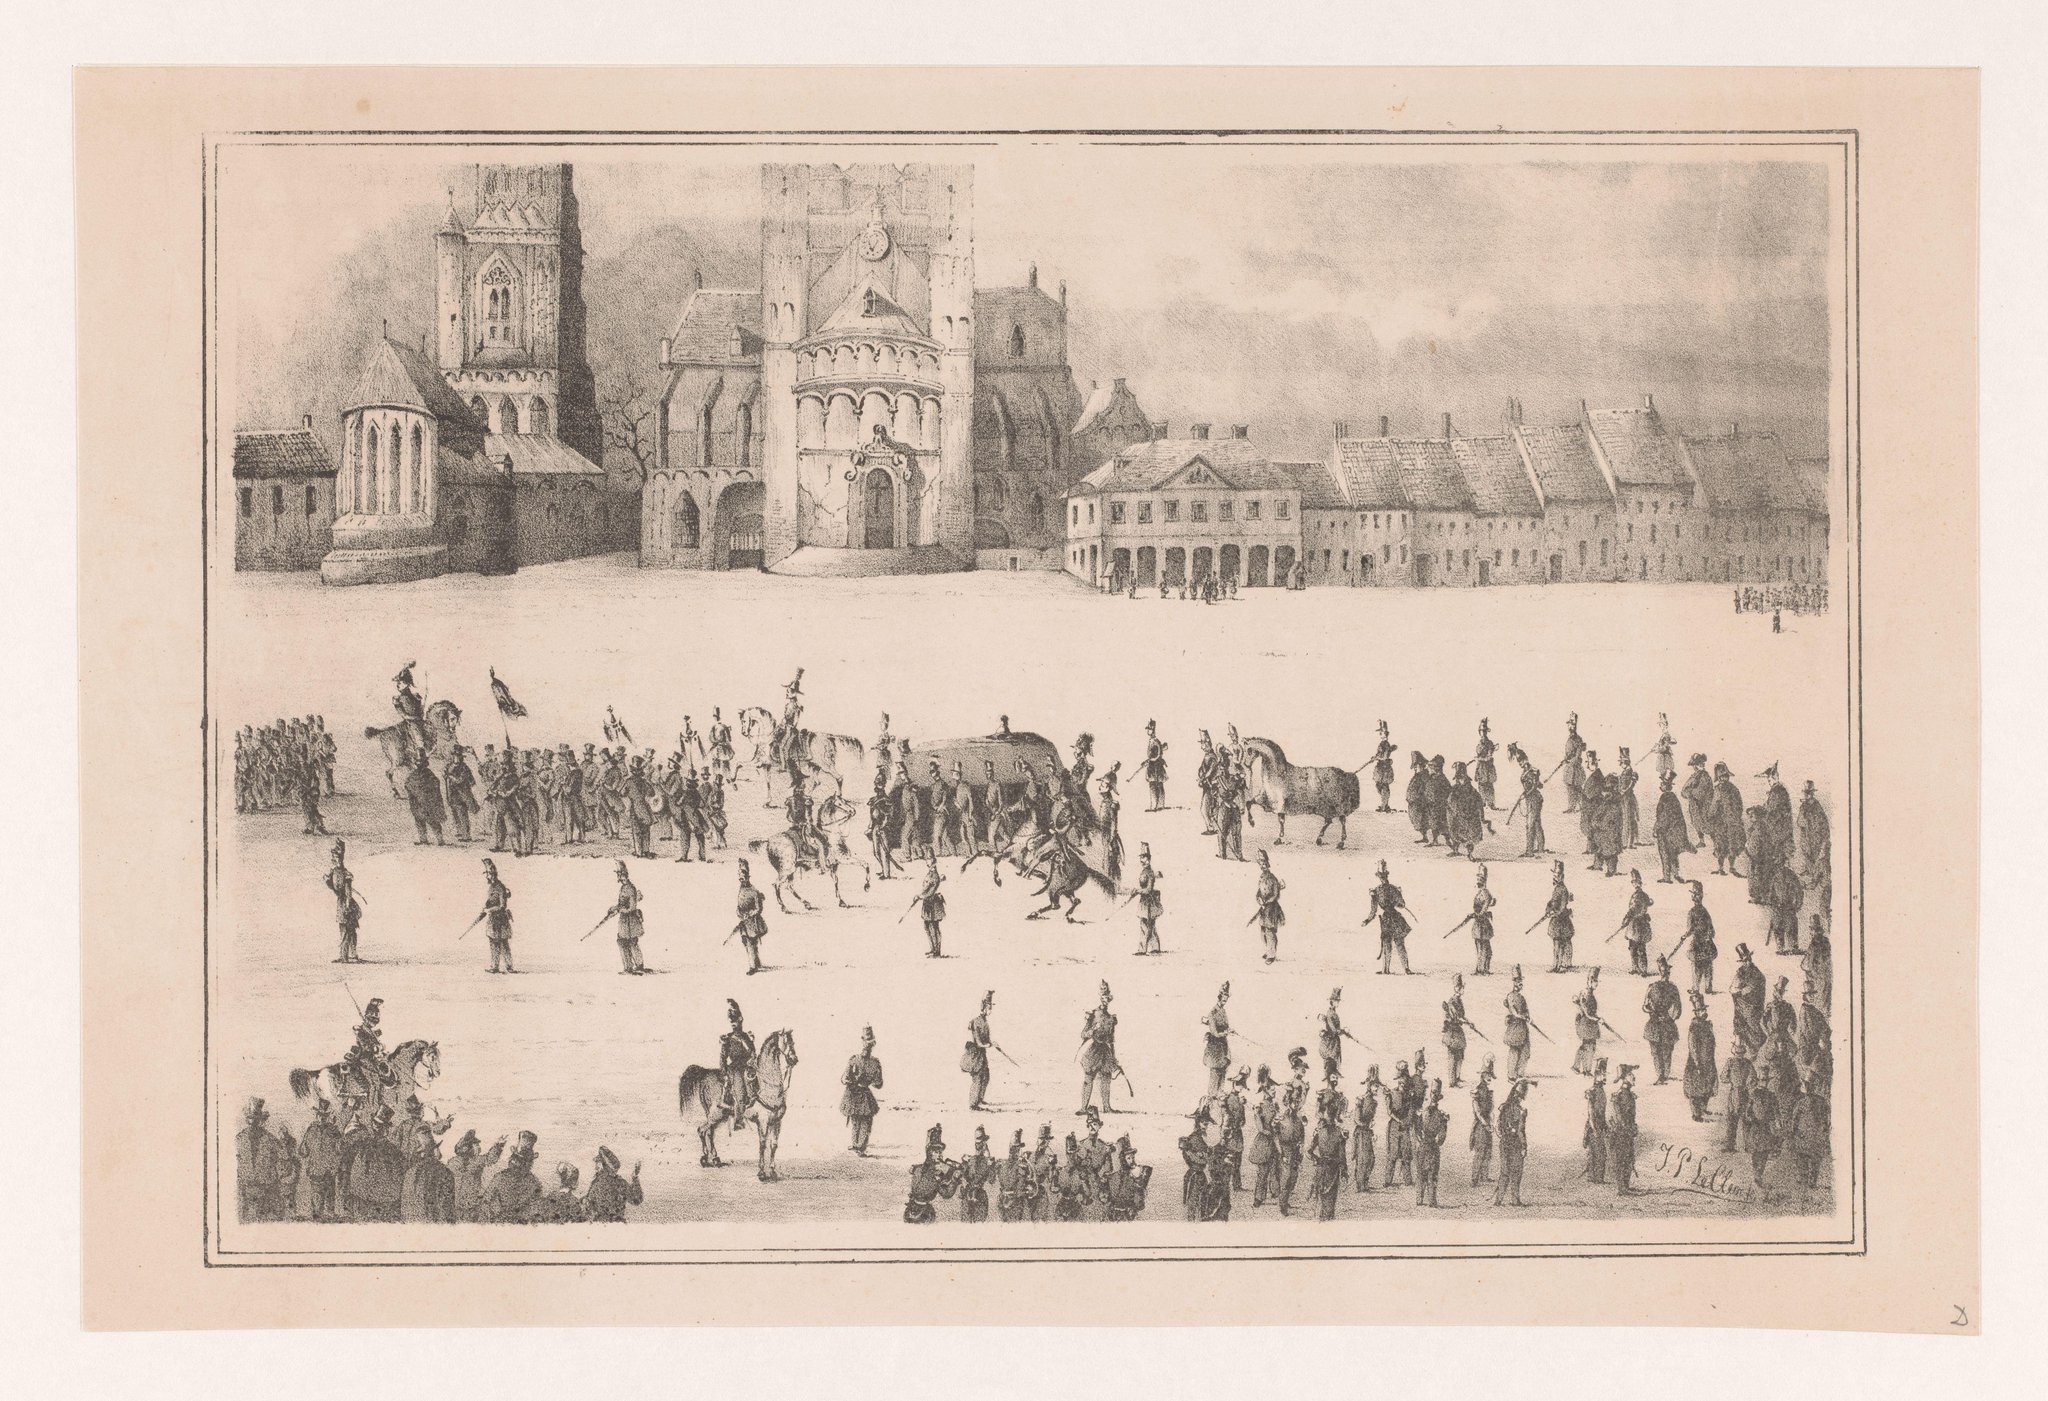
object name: print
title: Begrafenisstoet van Andries Jan Jacob Baron des Tombe te Maastricht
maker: jacques philippe le clerc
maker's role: print maker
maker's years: 1820-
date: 1845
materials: paper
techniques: lithograph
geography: netherlands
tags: funerary ceremonial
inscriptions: collector's mark: Lugt 2228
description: Begrafenis van luitenant-generaal A.J.J. Baron des Tombe, commandeur van Maastricht, overleden op 18 februari 1845. De begrafenisstoet trekt naar links over het Vrijthof. De lijkkist, gedragen door twaalf militairen, wordt vooraf gegaan door muzikanten in burgerkleding. Achter het lijk volgt het paard van den overledene en militaire muzikanten sluiten de stoet. In de achtergrond de Sint-Servaasbasiliek.